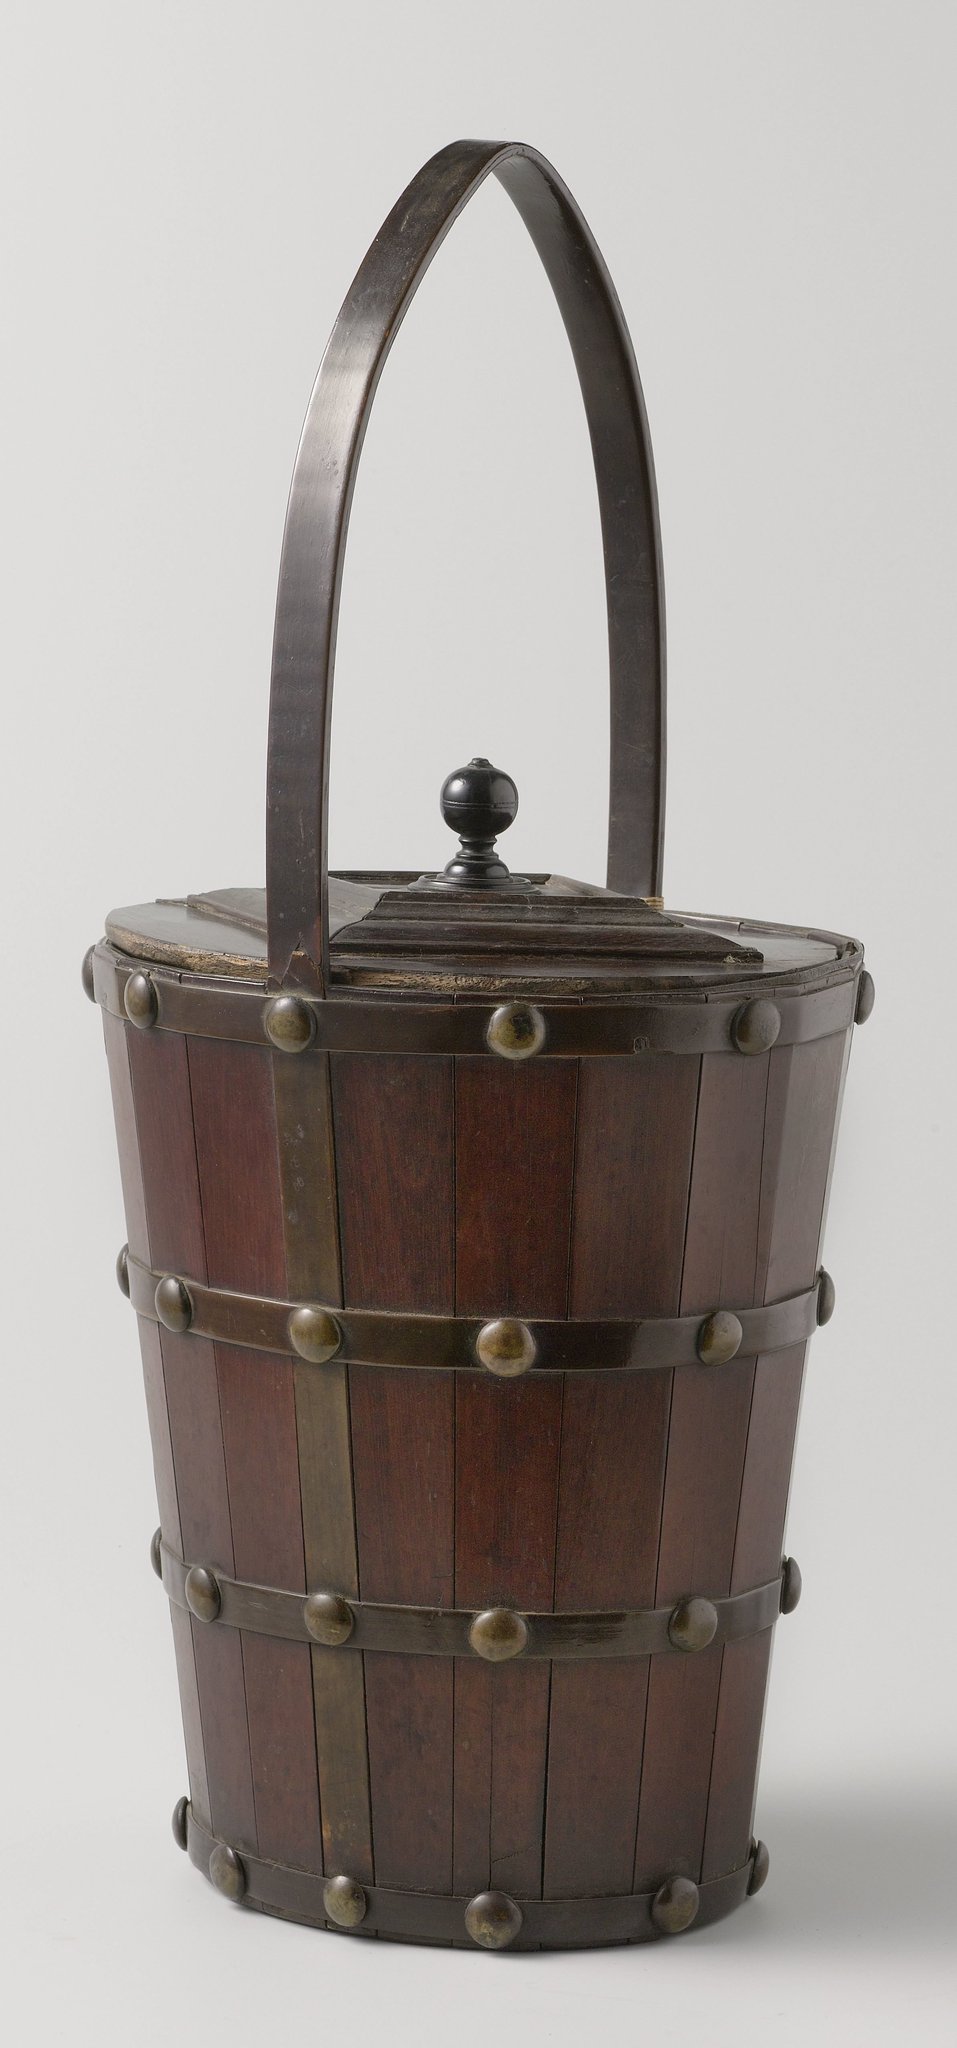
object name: mopsjestrommel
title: Emmer gebruikt om liedboekjes in te dragen, de zogenaamde mopsjestrommel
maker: Anonymous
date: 1770-1830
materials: baleen, copper, wood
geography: netherlands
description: Houten emmer met baleinen hengsel en banden en koperen knoppen. Houten scharnierend deksel met knop in ruitvormige reliëfversiering.